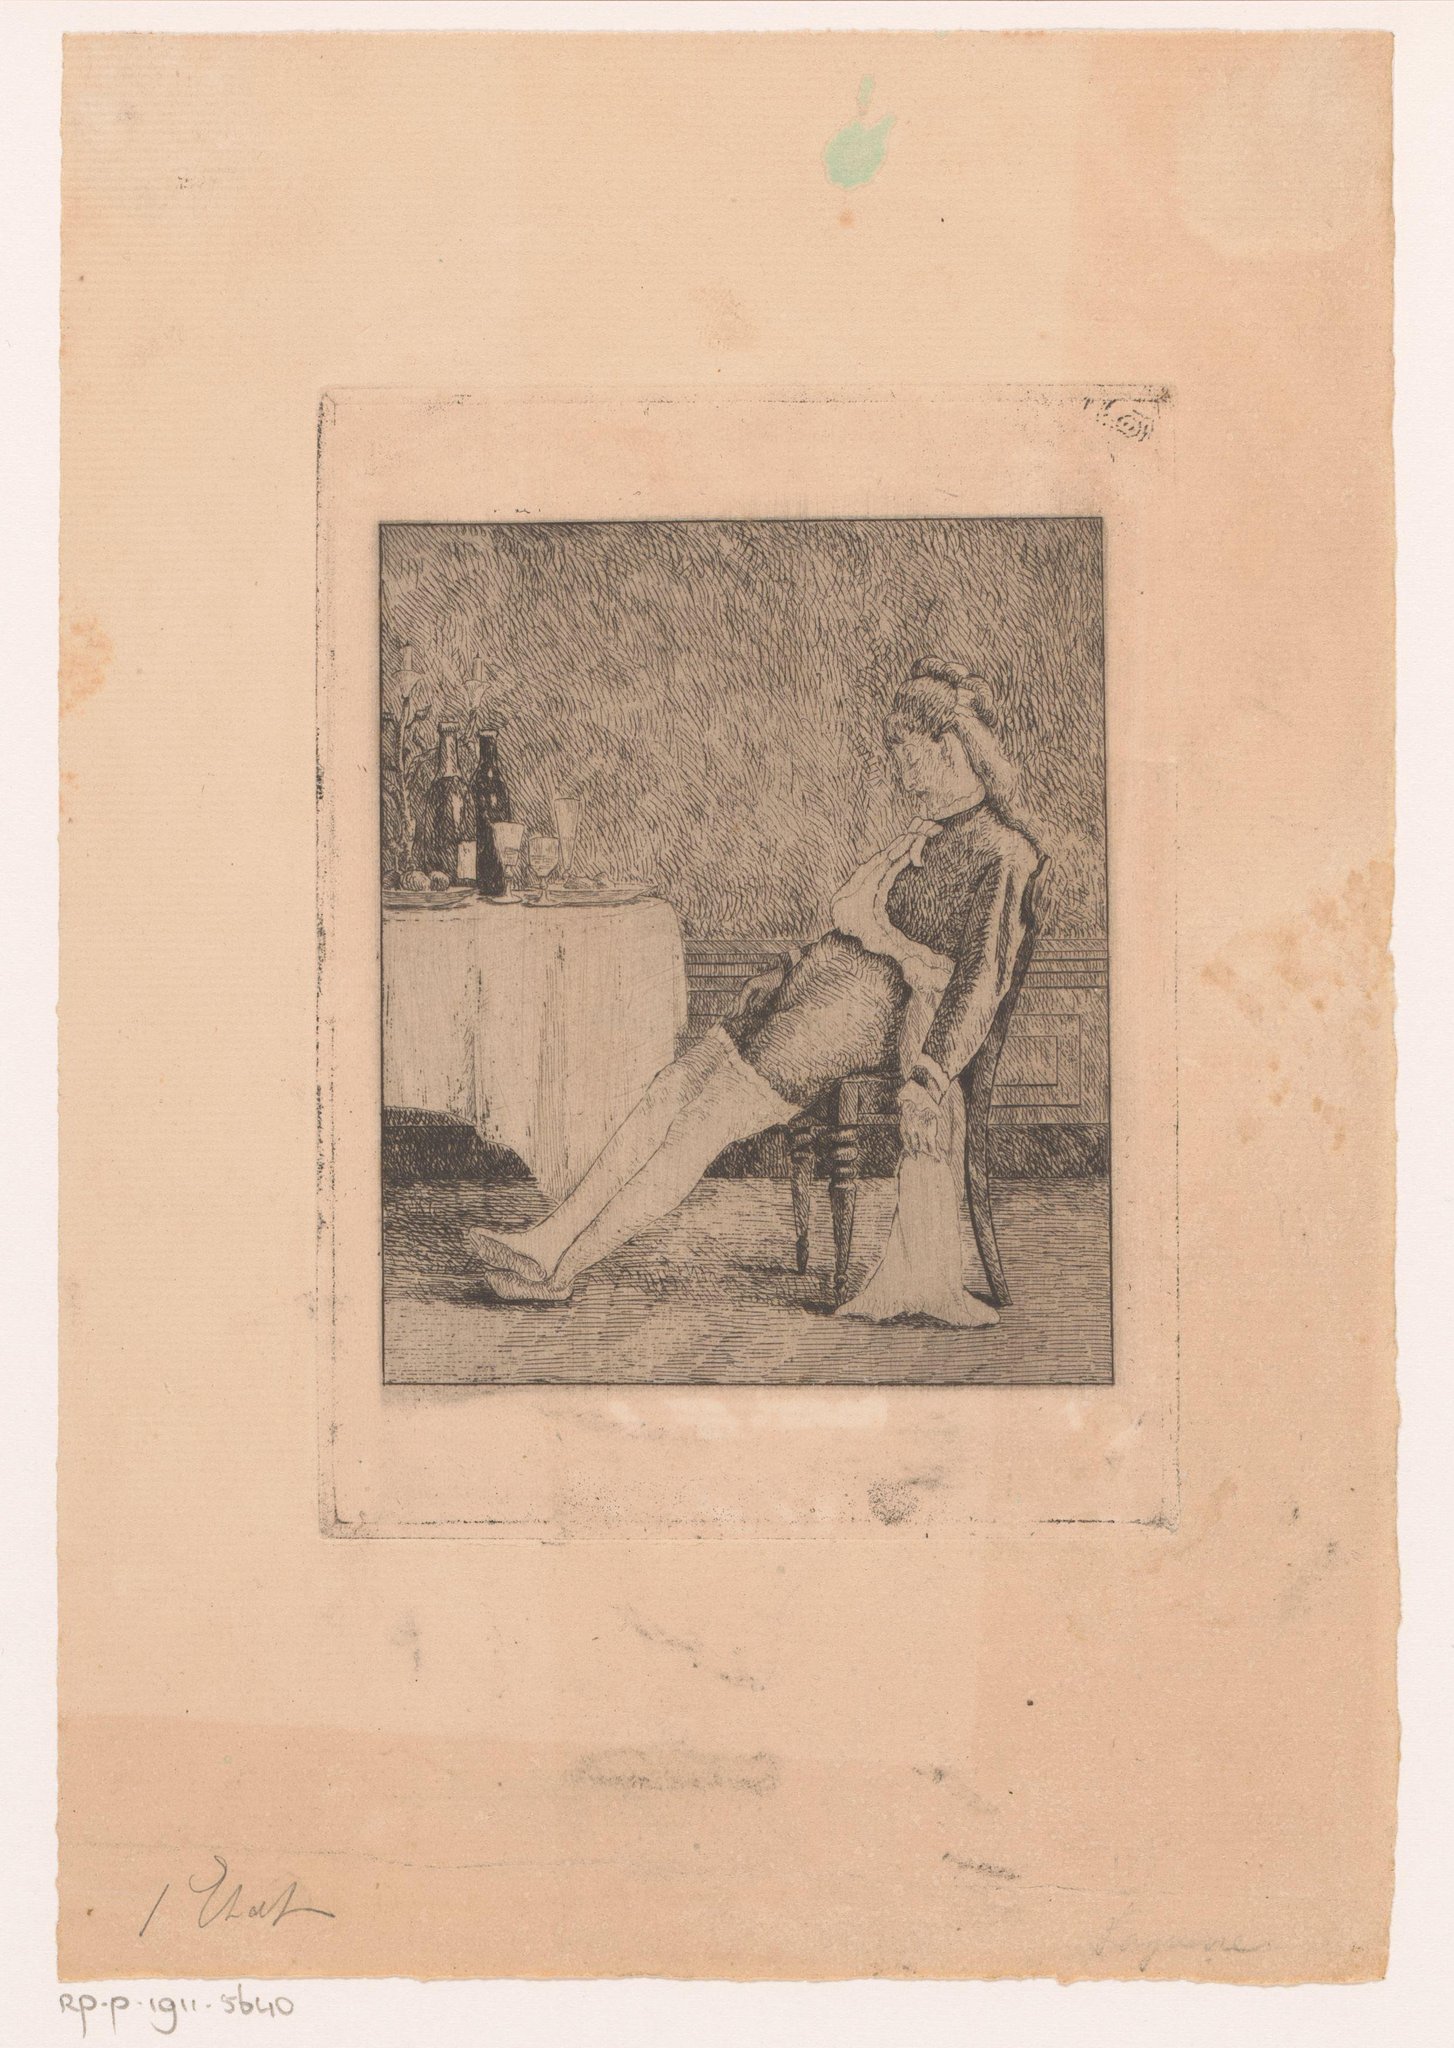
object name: print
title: Jonge vrouw onderuitgezakt in een stoel aan een tafel met daarop de resten van het diner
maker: g. laguesse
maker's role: print maker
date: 1877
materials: paper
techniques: etching, intaglio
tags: evening meal, dinner, supper (+ lingering at table)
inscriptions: collector's mark: Lugt 2228, annotation: ‘1 Etat’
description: Sterfdatum prentmaker onbekend. Derhalve is voor bepaling van de rechten van dit object de vervaardigingsdatum aangehouden.